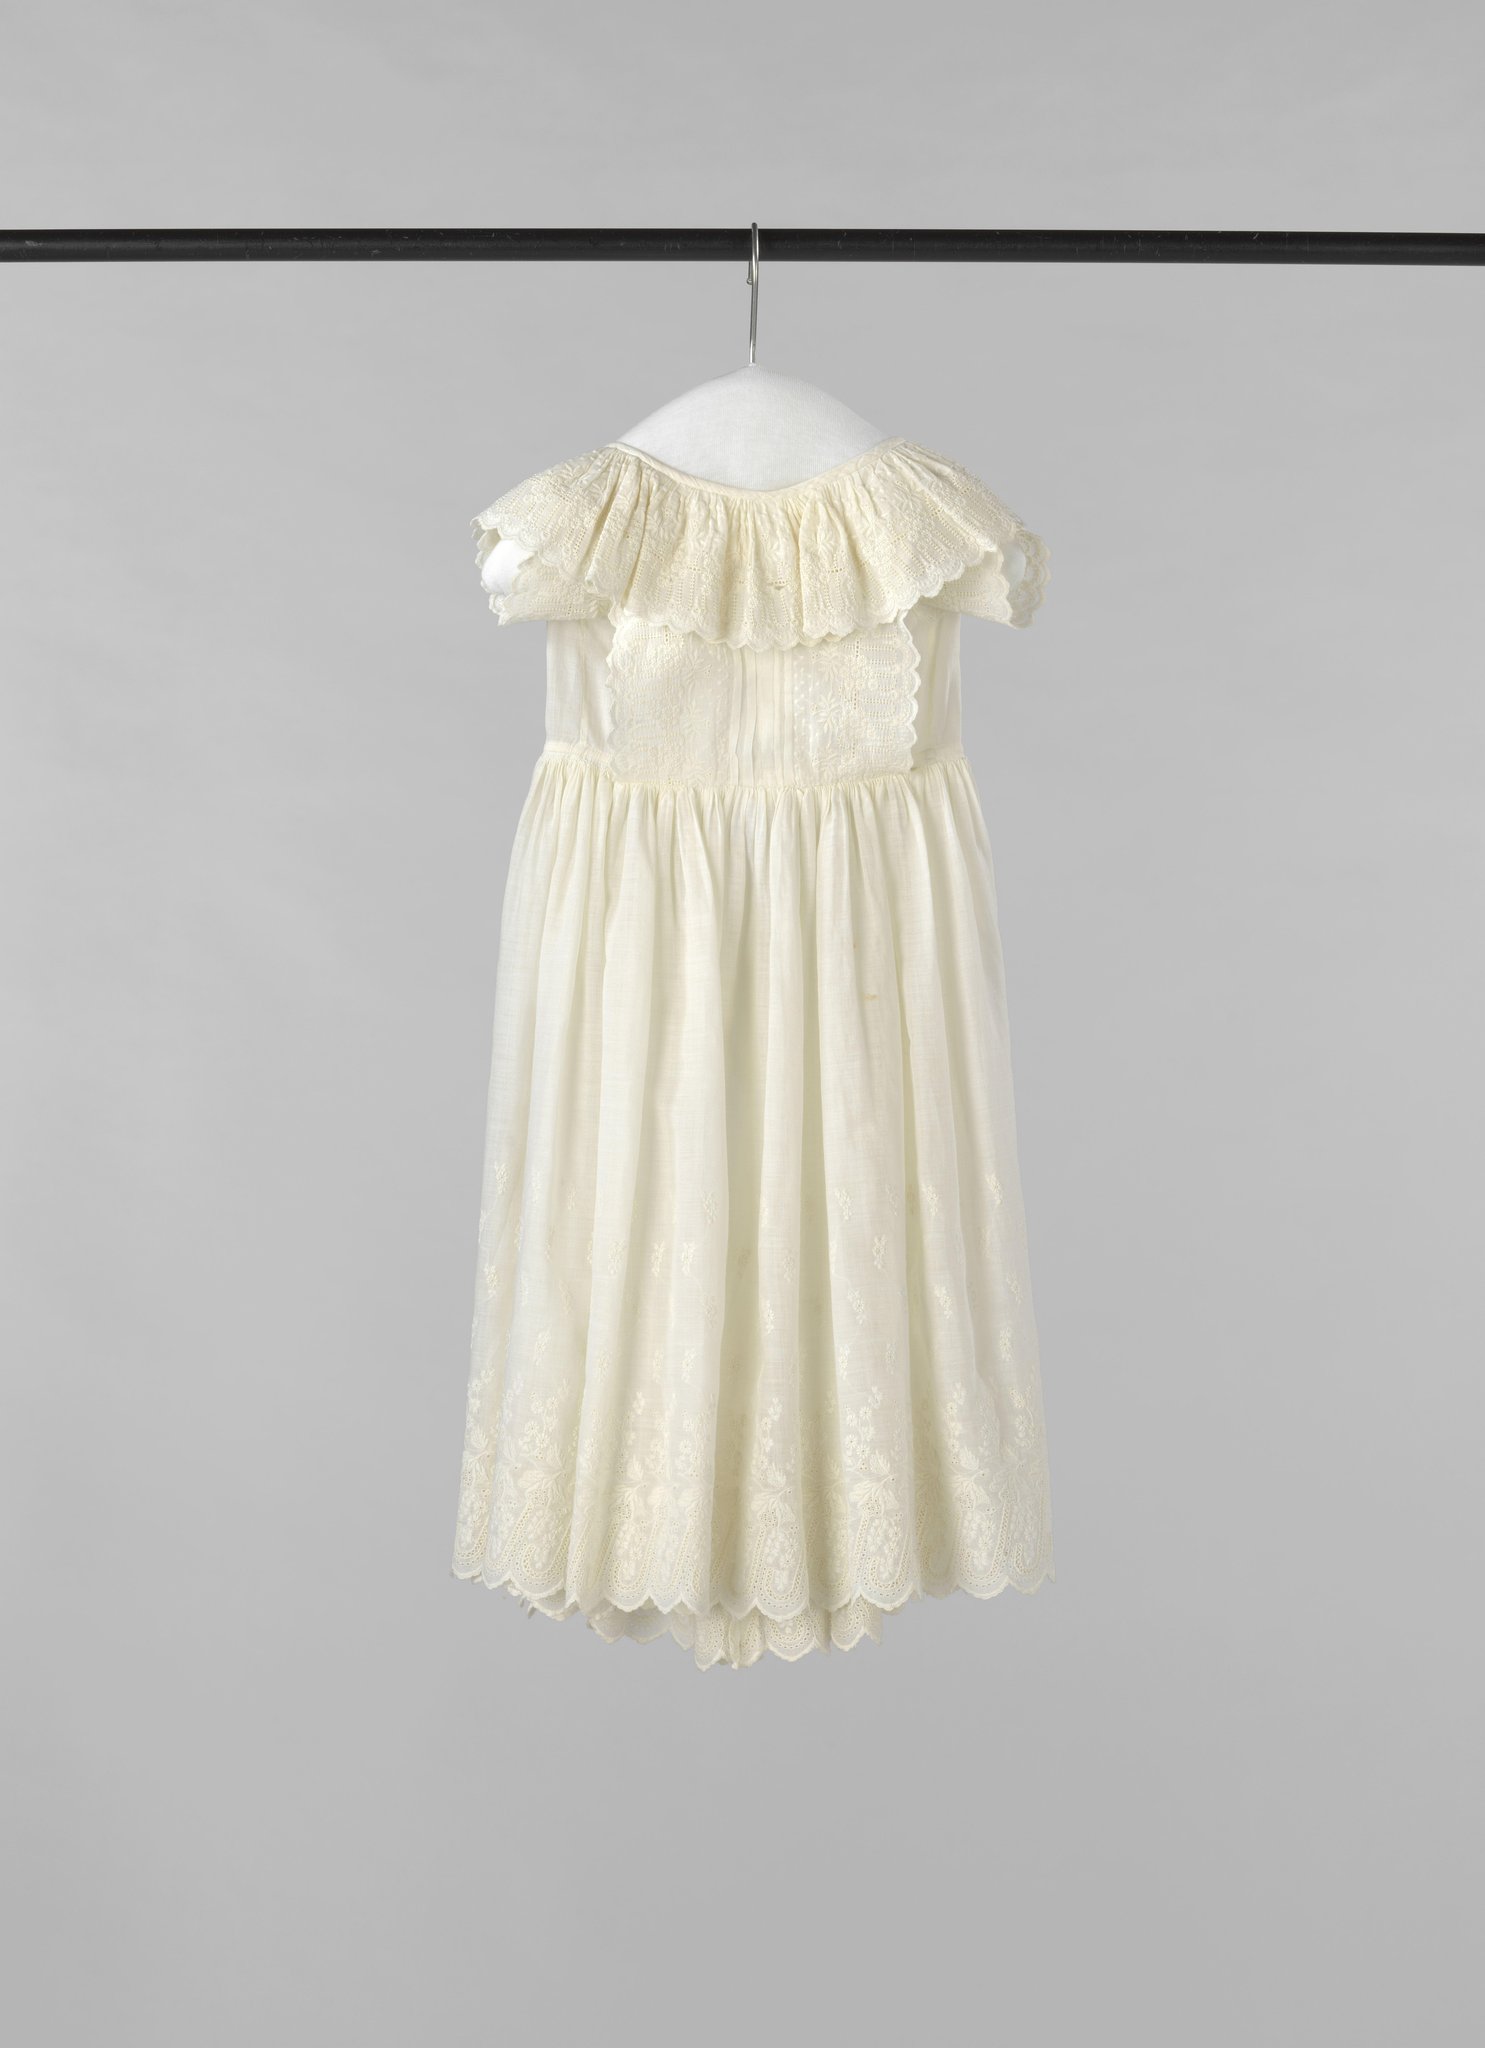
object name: girls' wear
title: kleuterjurkje, voor meisjes en jongetjes, van machinale geborduurde randstof van katoen, met schulpen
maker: Anonymous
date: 1890-1895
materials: cotton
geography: amsterdam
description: Kleuterjurkje, voor meisjes en jongetjes, van machinale geborduurdle randstof van katoen, met schulpen. Model: glad lijfje met van voren staande op rijgjes, wijde ronde hals met biesje, waaronder een gerimpelde strook rondom afhangt, Mouwtje van een op de schouder over elkaar geslagen, glad aangezitte strook. Achtersluiting met één parelmoeren knoopje en bandjes. Eén baans rokje, ruim en regelmatig gerimpeld. Randpatroon: Schulprand met lopend patroon van schuin rechts gerichte J. S., daarboven een naar links gerichte hangende bloem met een bloemtrosje dat in elke schulp hangt en een tweede dat omhoog staat. Daarboven rijtjes van losse bloemtakjes. Toestand: In 1979 gewassen.